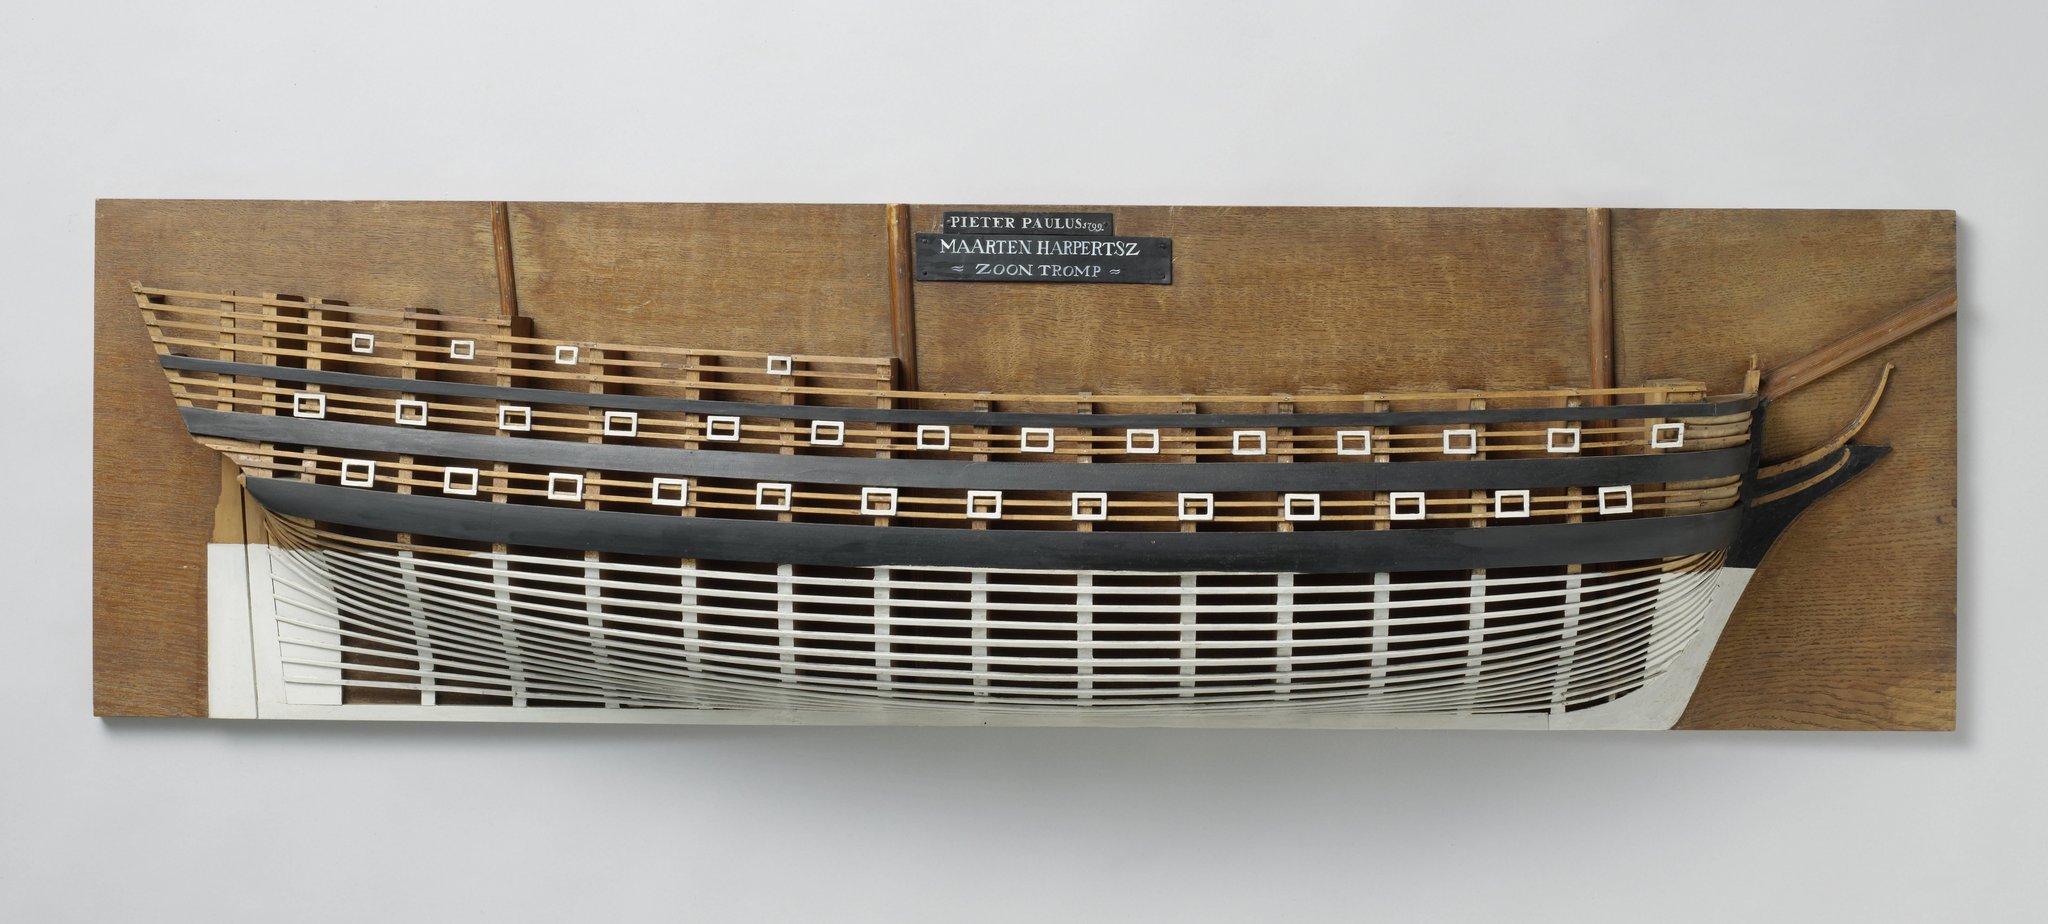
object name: half model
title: Half Model of a 68-Gun Ship of the Line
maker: Anonymous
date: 1798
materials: wood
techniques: polychromy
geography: netherlands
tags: utrecht (schip), admiraal tromp (schip), pieter paulus (schip)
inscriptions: inscription, top centre, on two square black metal labels: ‘PIETER PAULUS 1799. // MAARTEN HARPERTS / ZOON TROMP’